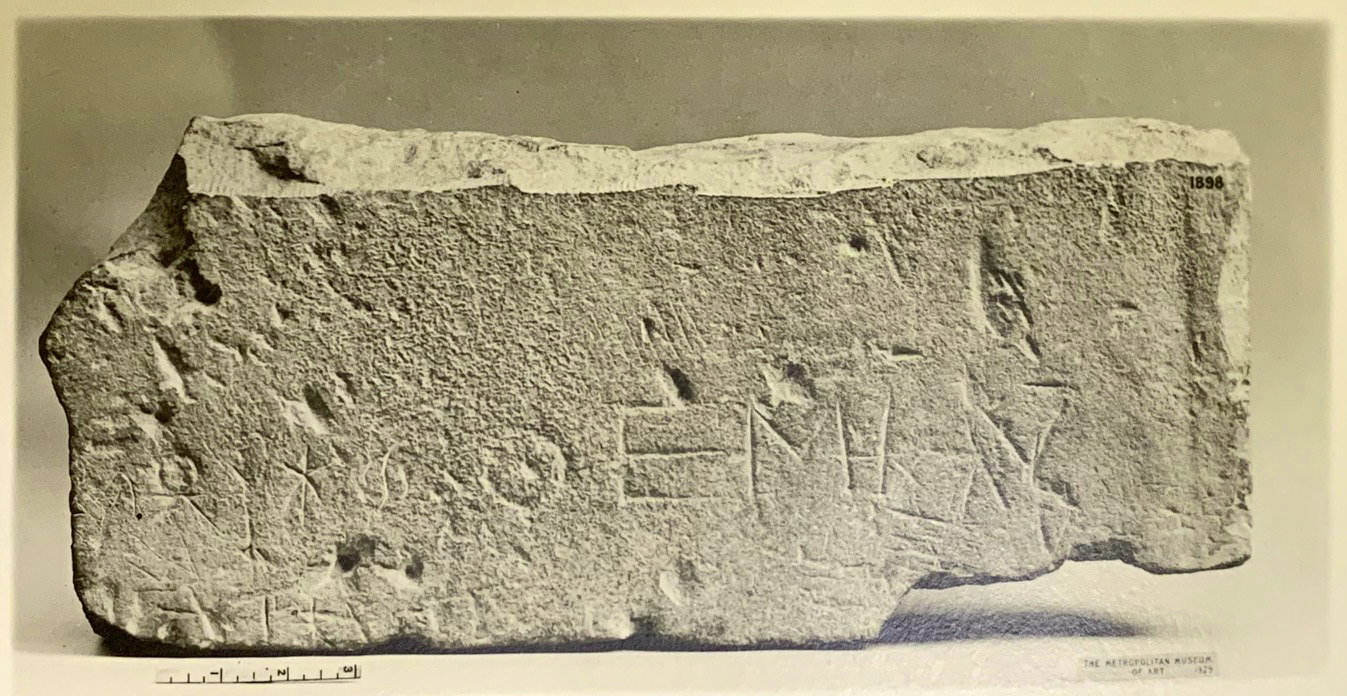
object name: block, inscribed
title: Limestone inscribed block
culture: cypriot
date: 500-401 BCE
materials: limestone